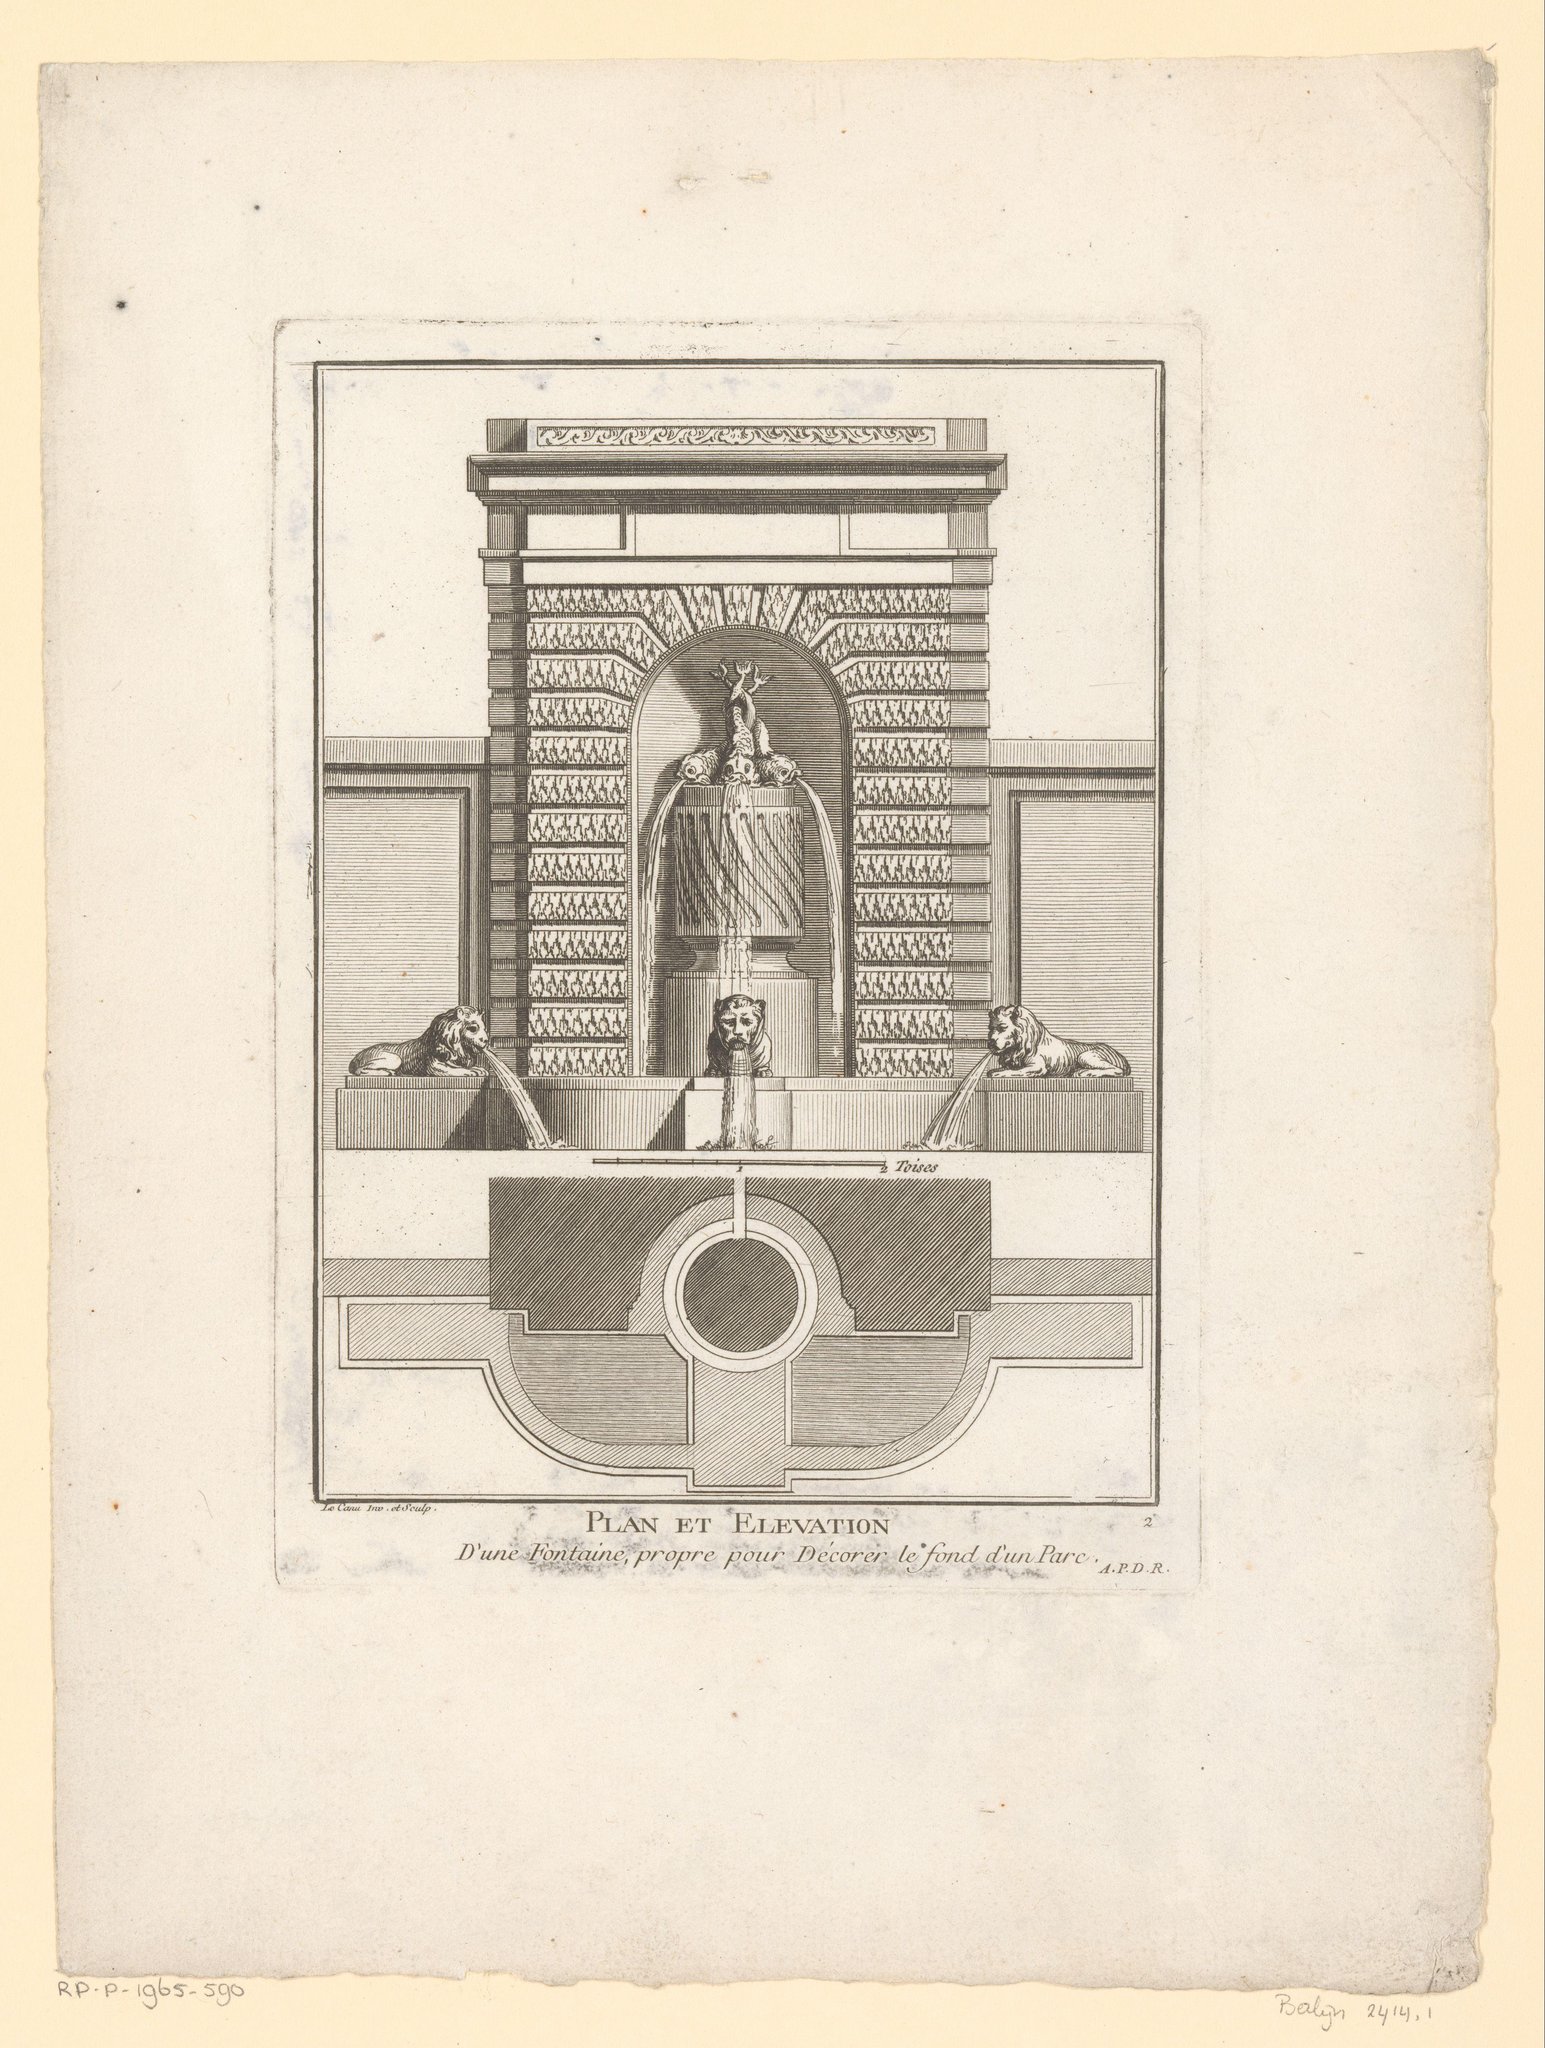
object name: print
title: 1er Cahier Élévations De Fontaines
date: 1778-1782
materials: paper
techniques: etching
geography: paris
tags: dolphin ~ ornament, ornamental fountain, beasts of prey, predatory animals: lion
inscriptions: collector's mark: Lugt 2228, collector's mark: Lugt 2760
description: Vooraanzicht en plattegrond van een geornamenteerde fontein met drie leeuwen en drie dolfijnen op een voetstuk in een halfronde nis.